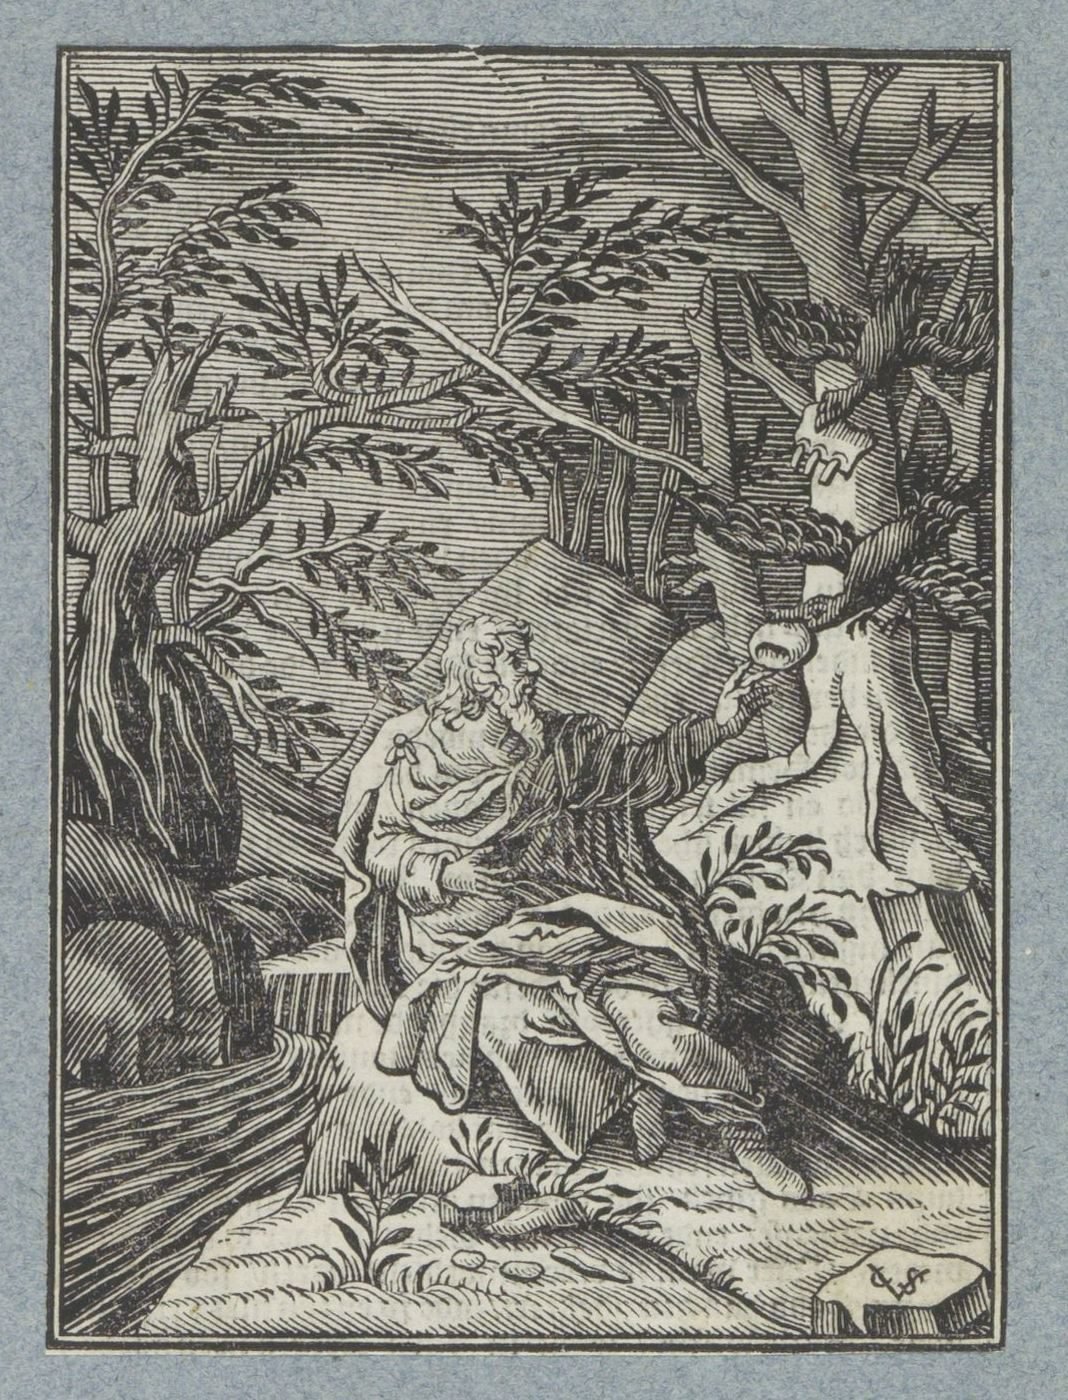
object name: album leaf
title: Elia gevoed door de raven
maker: pieter jacobsz. paets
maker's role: publisher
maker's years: 1587-1667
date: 1645-1646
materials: paper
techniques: letterpress printing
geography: amsterdam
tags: elijah fed by the raven(s): while the prophet is living by the brook, ravens bring him food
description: De prent werd gemaakt voor de uitgaven van P.J. Paets uit Amsterdam. Ze komt in ieder geval voor in: Bibels Tresoor ofte der zielen lusthof. Amsterdam, P.J. Paets, 1646. Mogelijk ook in: Historien ende Prophetien. [Amsterdam], P.J. Paets, 1645.